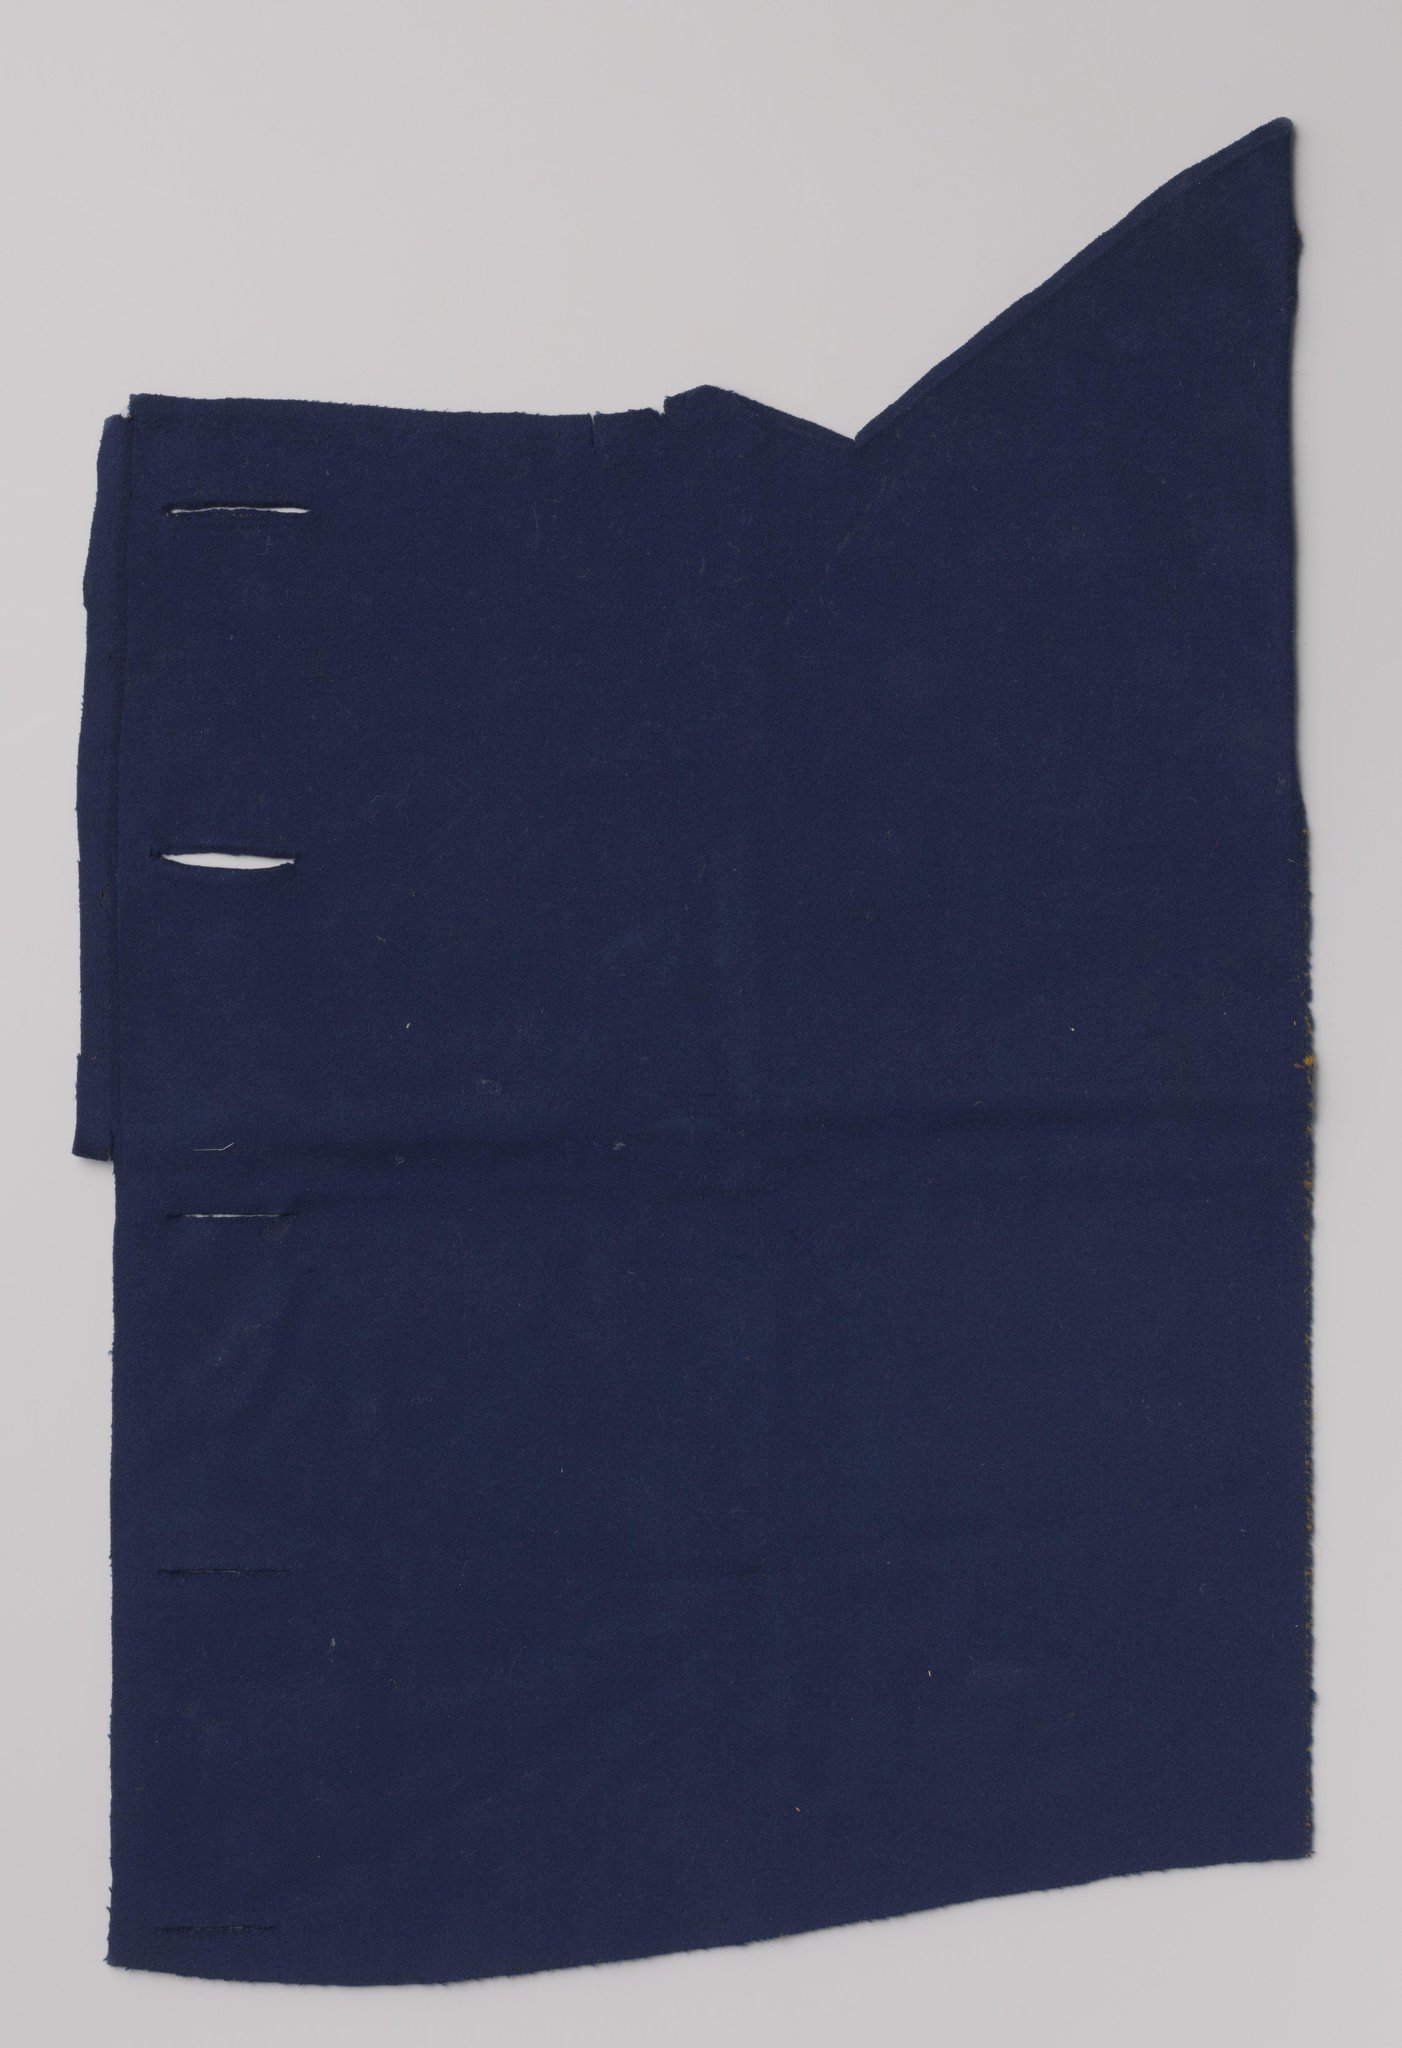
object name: borstlap, maagstuk, borststuk, devant de gorge, plastron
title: Borststuk, restant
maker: Anonymous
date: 1800-1850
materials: textile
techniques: weave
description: Borststuk, restant bestaande uit stuk blauw laken met vijf knoopsgaten (delen van stiksel). Aan een zijde restanten van geel stiksel. In pakket met etiket: Rijksmuseum, Amsterdam. Nederlandse leger, mariniers. Diverse stukjes uniformstof en/of uitmonsteringslaken. Kleine motbeschadigingen.